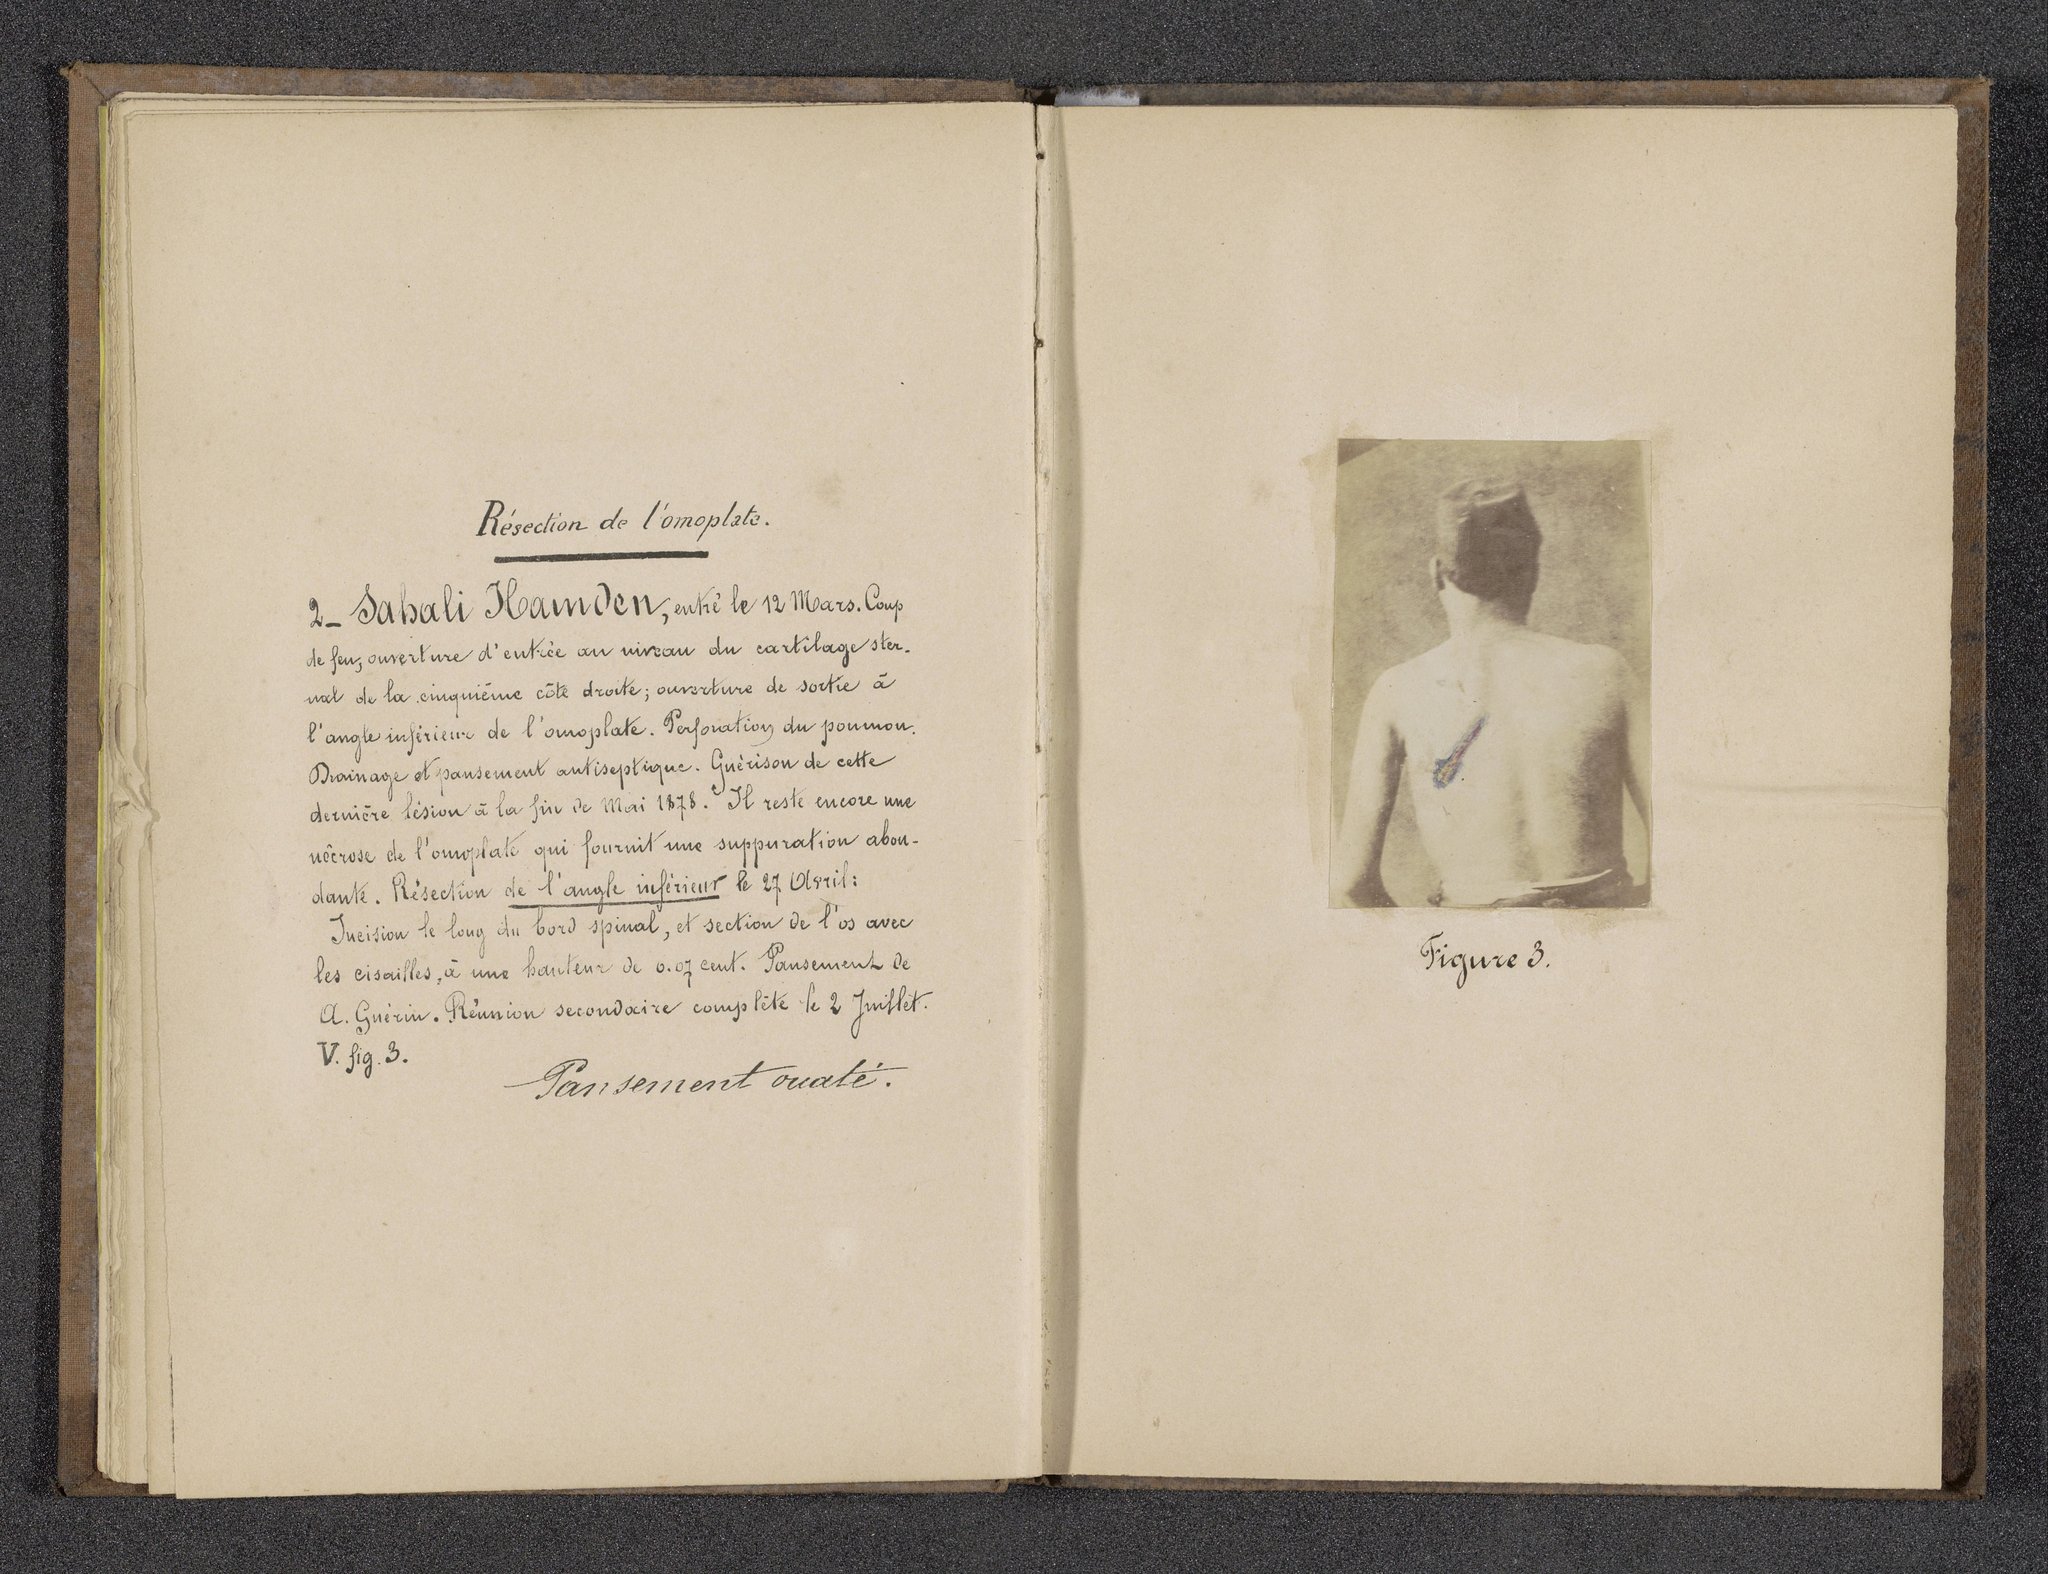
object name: page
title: Sahali Hainden, een patiënt met schotwond in zijn schouderblad, op de rug gezien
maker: Anonymous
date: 1878-1880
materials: photographic support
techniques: albumen print, hand coloring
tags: infections and wounds, patient, sick person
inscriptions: number: ‘Figure 3.’